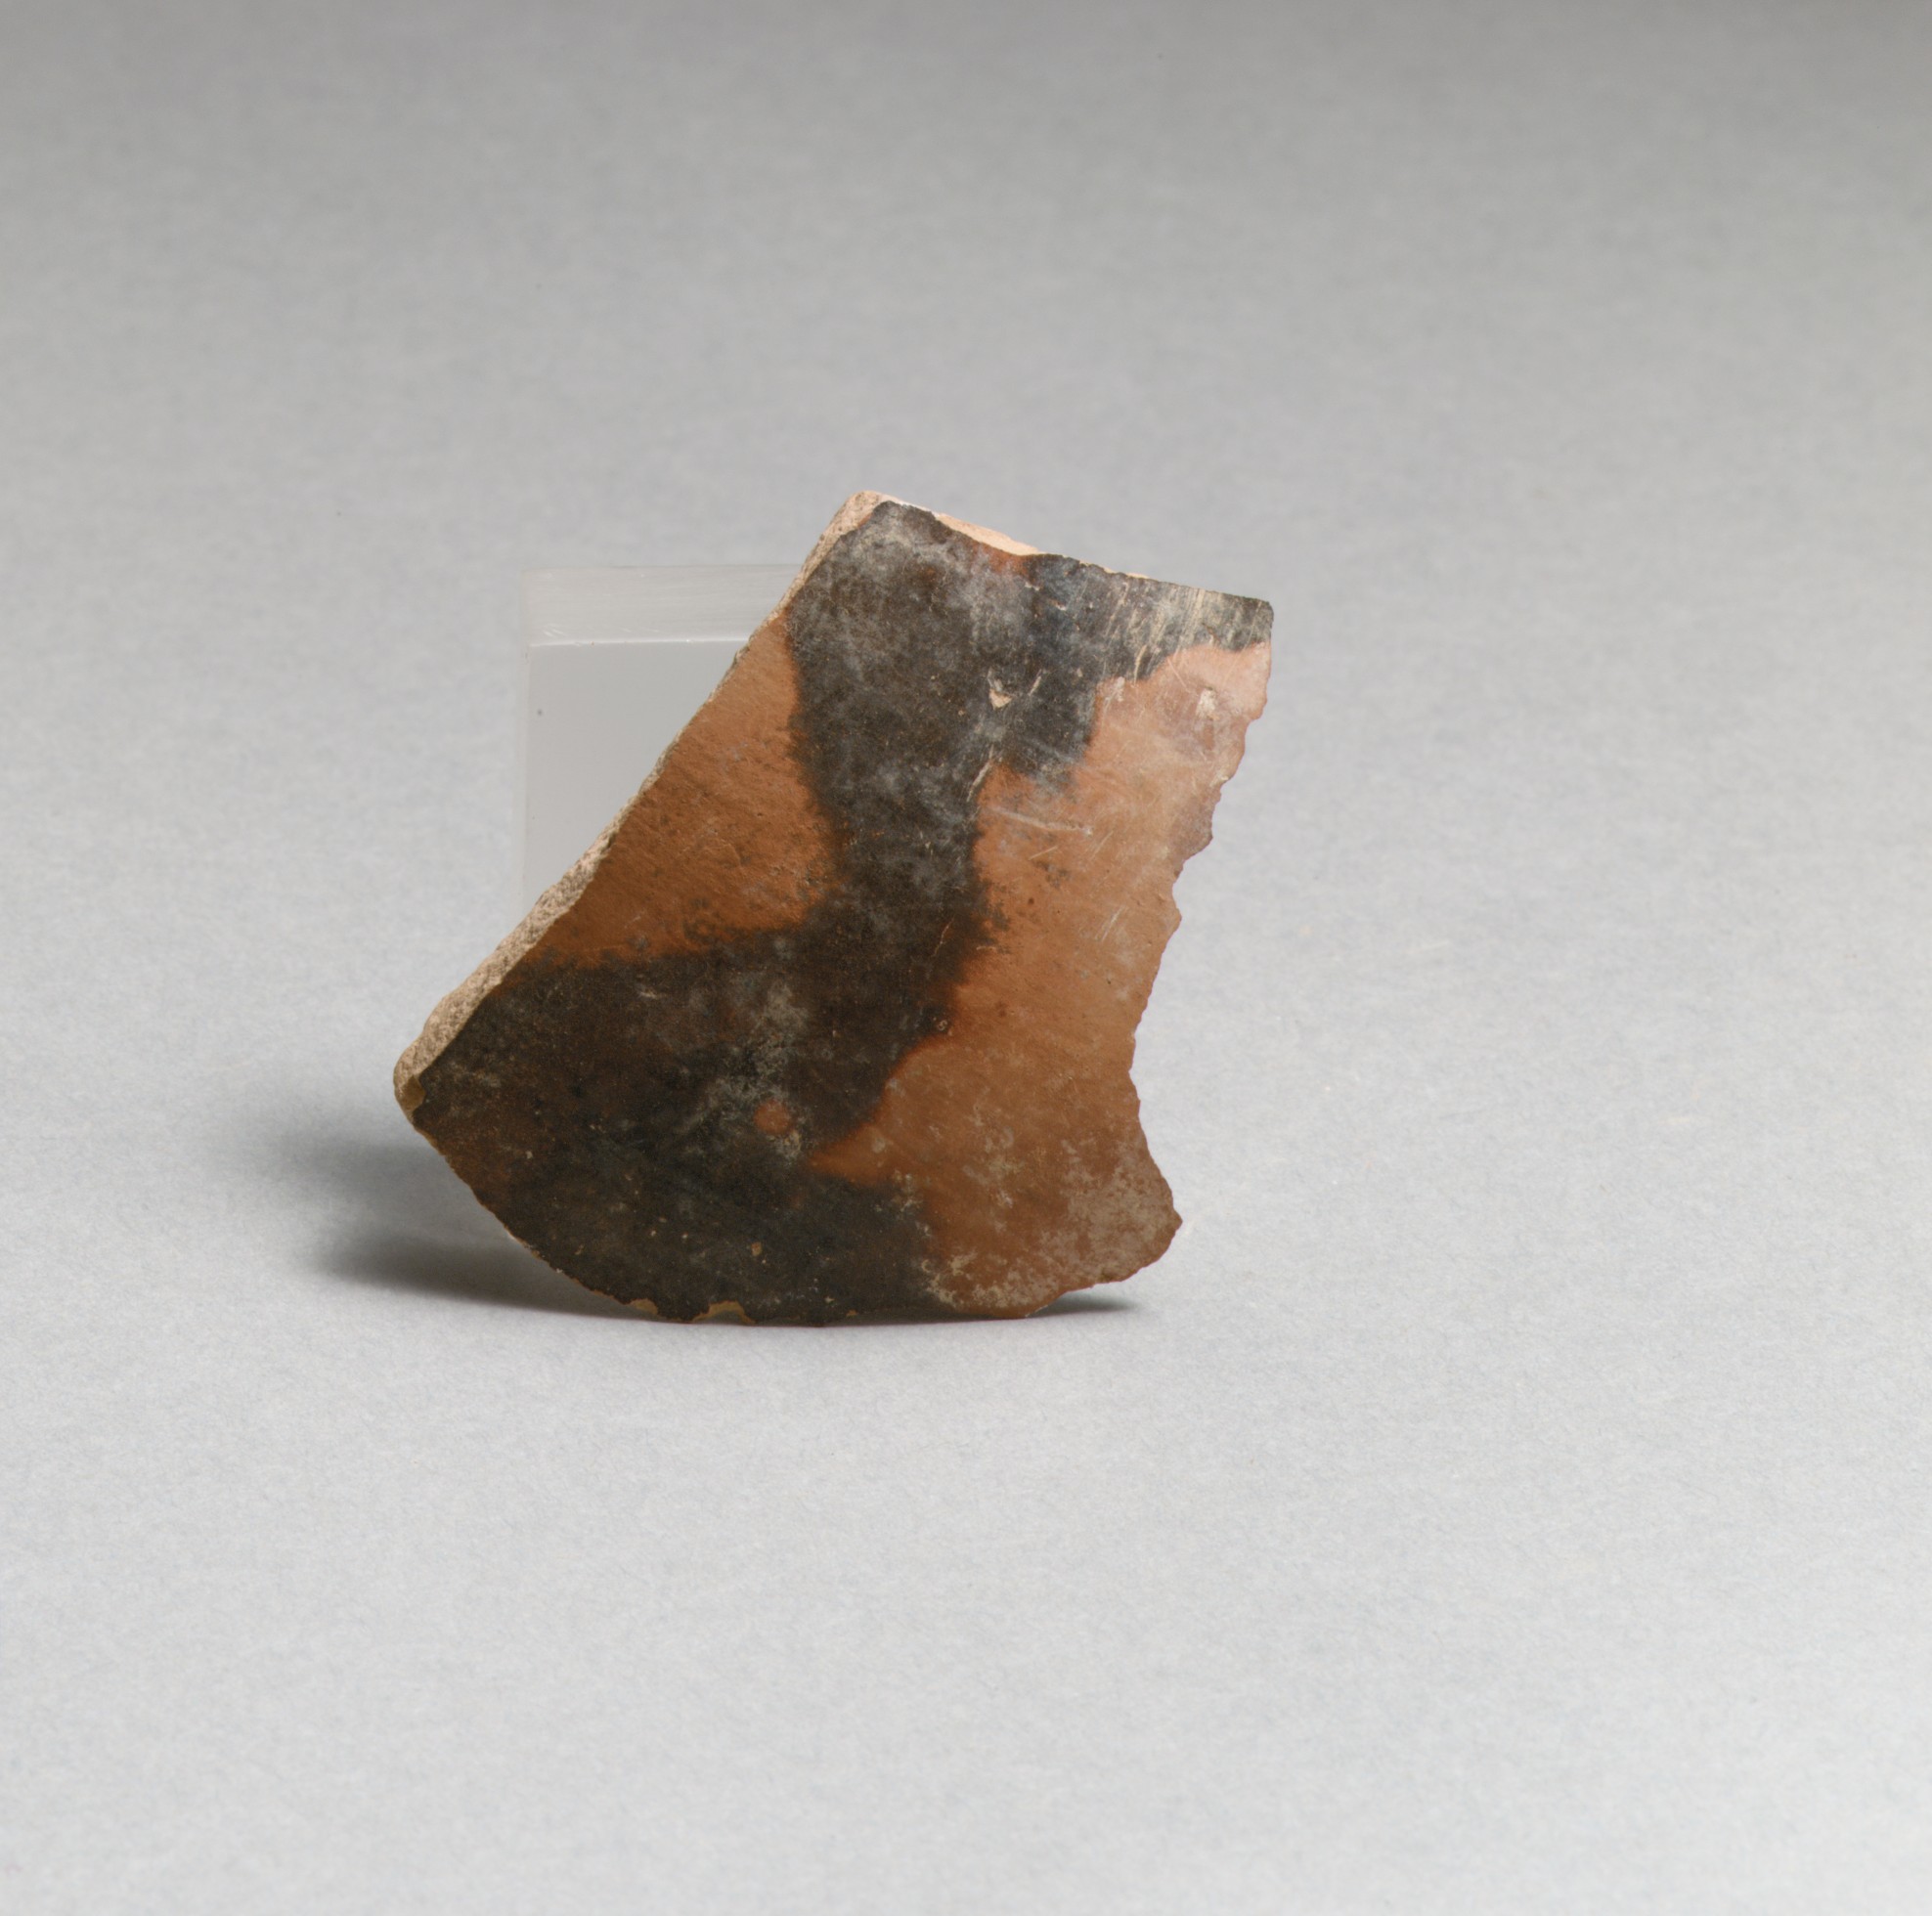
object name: vase fragment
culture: minoan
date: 2600-2000 BCE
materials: terracotta